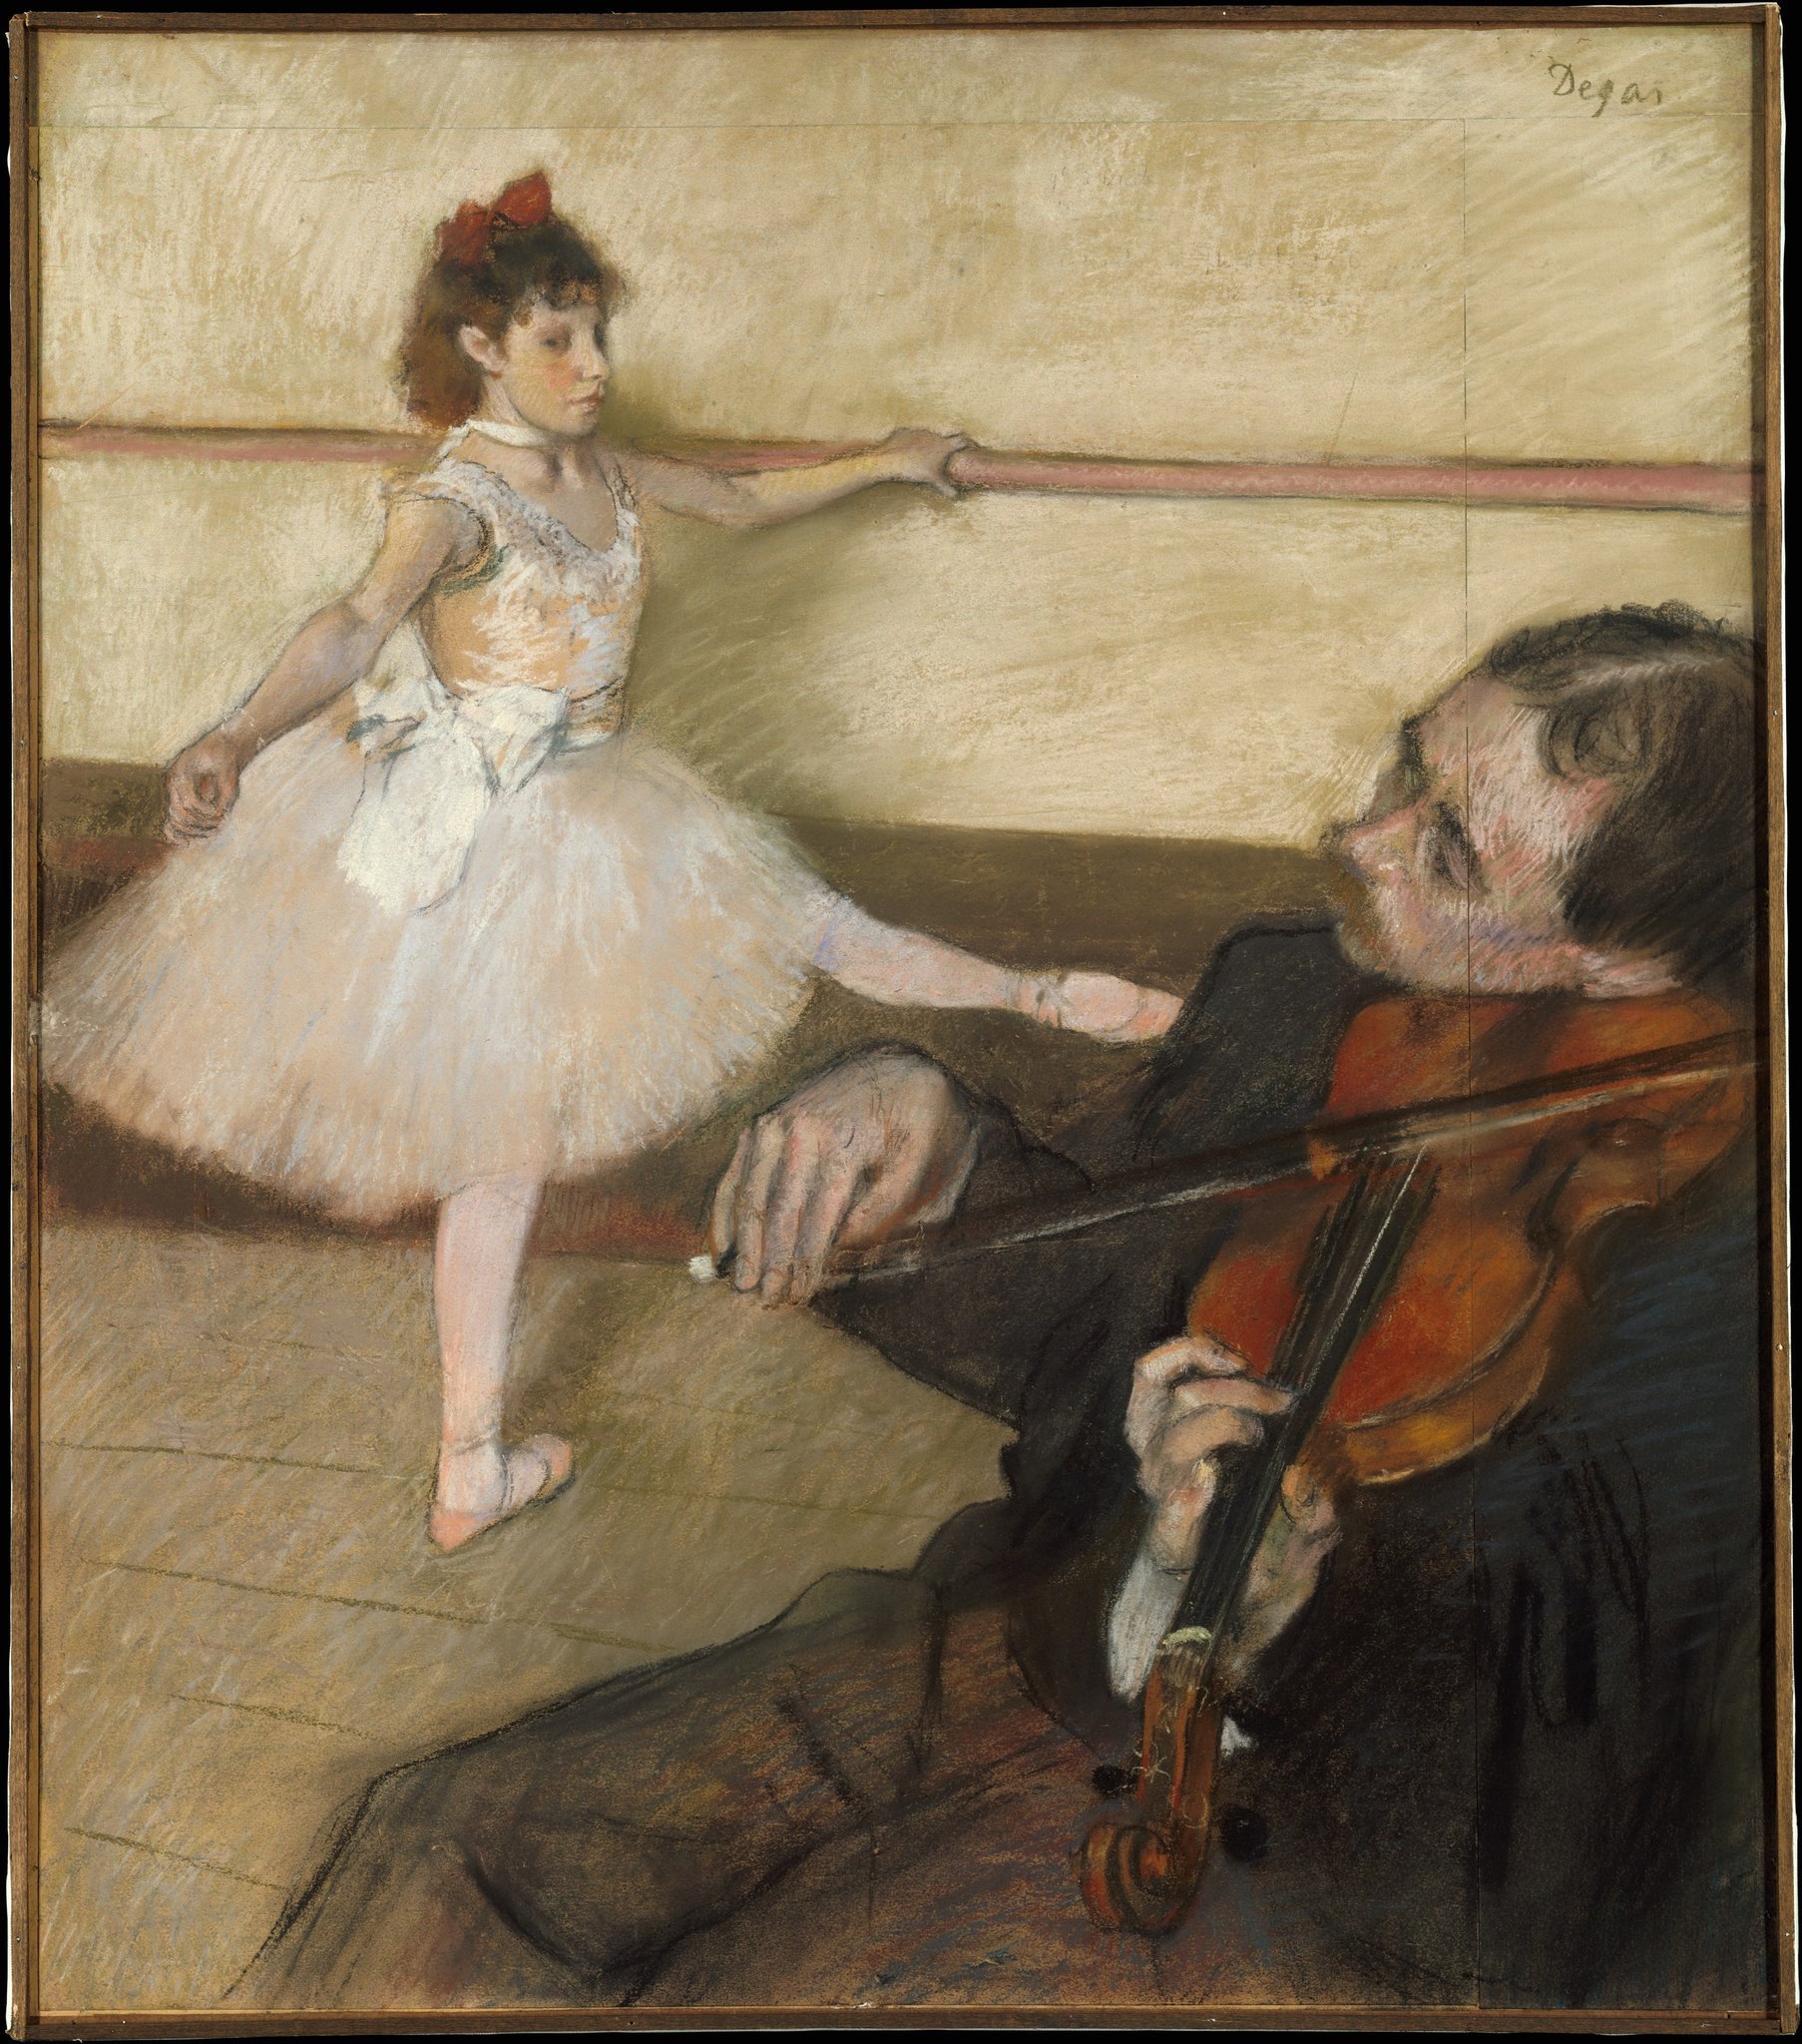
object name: drawing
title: The Dance Lesson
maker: edgar degas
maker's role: artist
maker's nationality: french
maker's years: 1834-1917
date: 1879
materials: chalk, pastel, paper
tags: men,women,dancing,violins,dancers,ballet